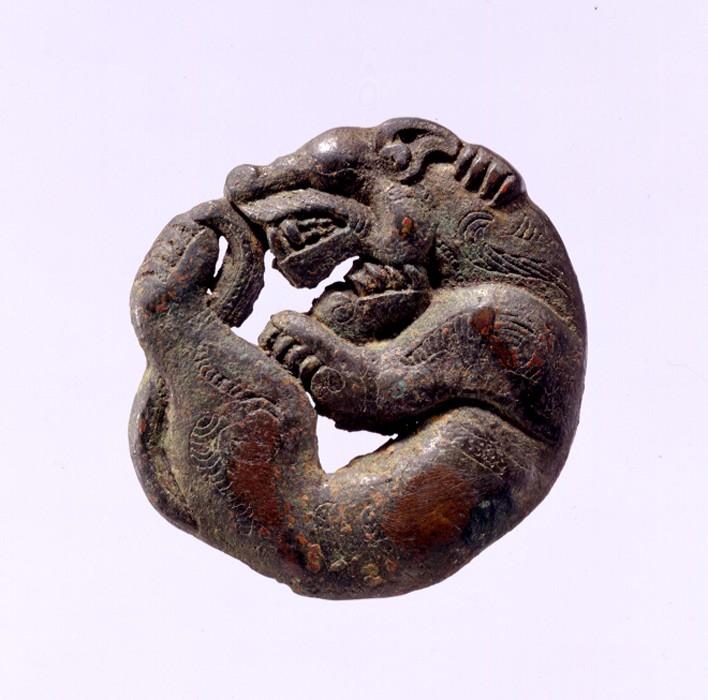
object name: strap crossing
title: Strap-Crossing in the Shape of a Coiled Wolf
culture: eastern eurasian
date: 500-401 BCE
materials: bronze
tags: animals